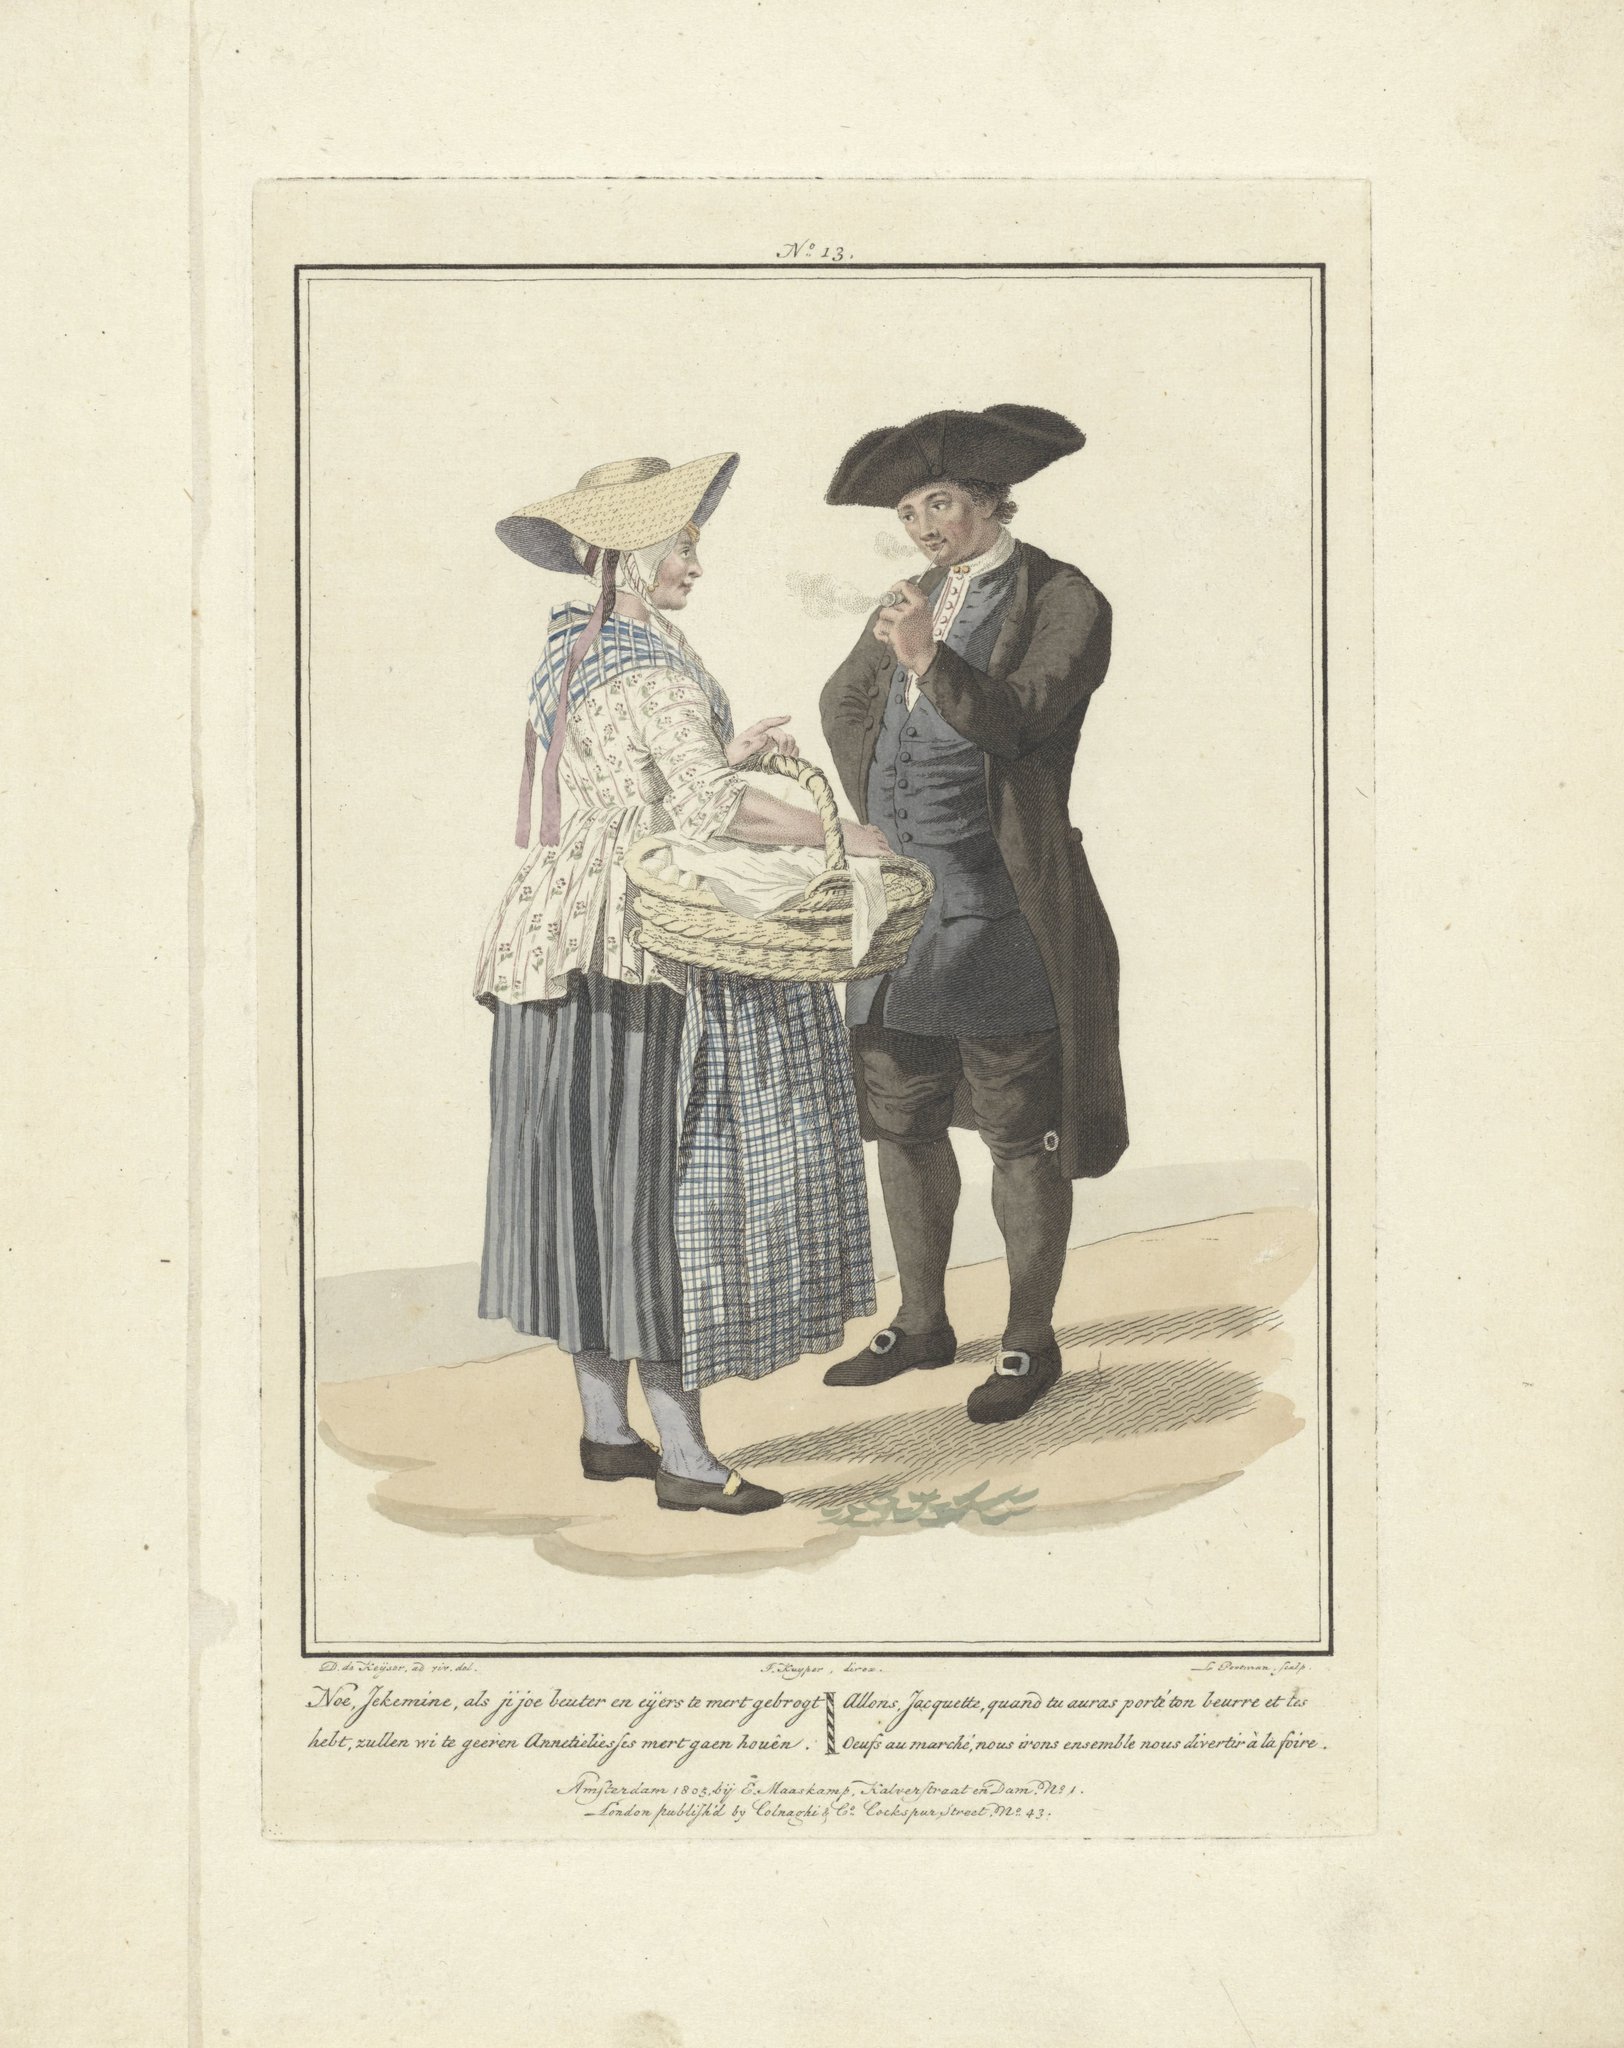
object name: book illustration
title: Noe, Jekemine, als ji joe beuter en eijers te mert gebrogt hebt, zullen wi te geeren Annetieliesses mert gaen houên / Allons, Jacquette, quand tu auras porté ton beurre et tes oeufs au marché, nous irons ensemble nous divertir à la foire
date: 1803-1807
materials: paper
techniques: etching, hand coloring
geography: amsterdam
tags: coat (+ men's clothes), going to the market, head-gear: hat (+ men's clothes), head-gear: hat (+ women's clothes), clothes, costume (+ men's clothes), folk costume, regional costume, eggs, egg-dishes, apron (+ women's clothes)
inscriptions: collector's mark: Lugt 2228, inscription: ‘Noe, Jekemine, als ji joe beuter en eijers te mert gebrogt hebt...Allons Jacuette, quand tu auras portét'on beurre et les oeufs au marché...; m.b.: no. 13’, signature and date: ‘r.o.: L. Portman sculp.; l.o.: D. de Keyser ad viv. del.; m.o. Amsterdam 1805, bij Maaskamp....London, published by Colnaghi & Cie...’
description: Illustratie uit: Afbeeldingen van de kleeding, zeden en gewoonten in de Bataafsche Republiek, met den aanvang der negentiende eeuw. Amsterdam: Evert Maaskamp, 1803-1807.